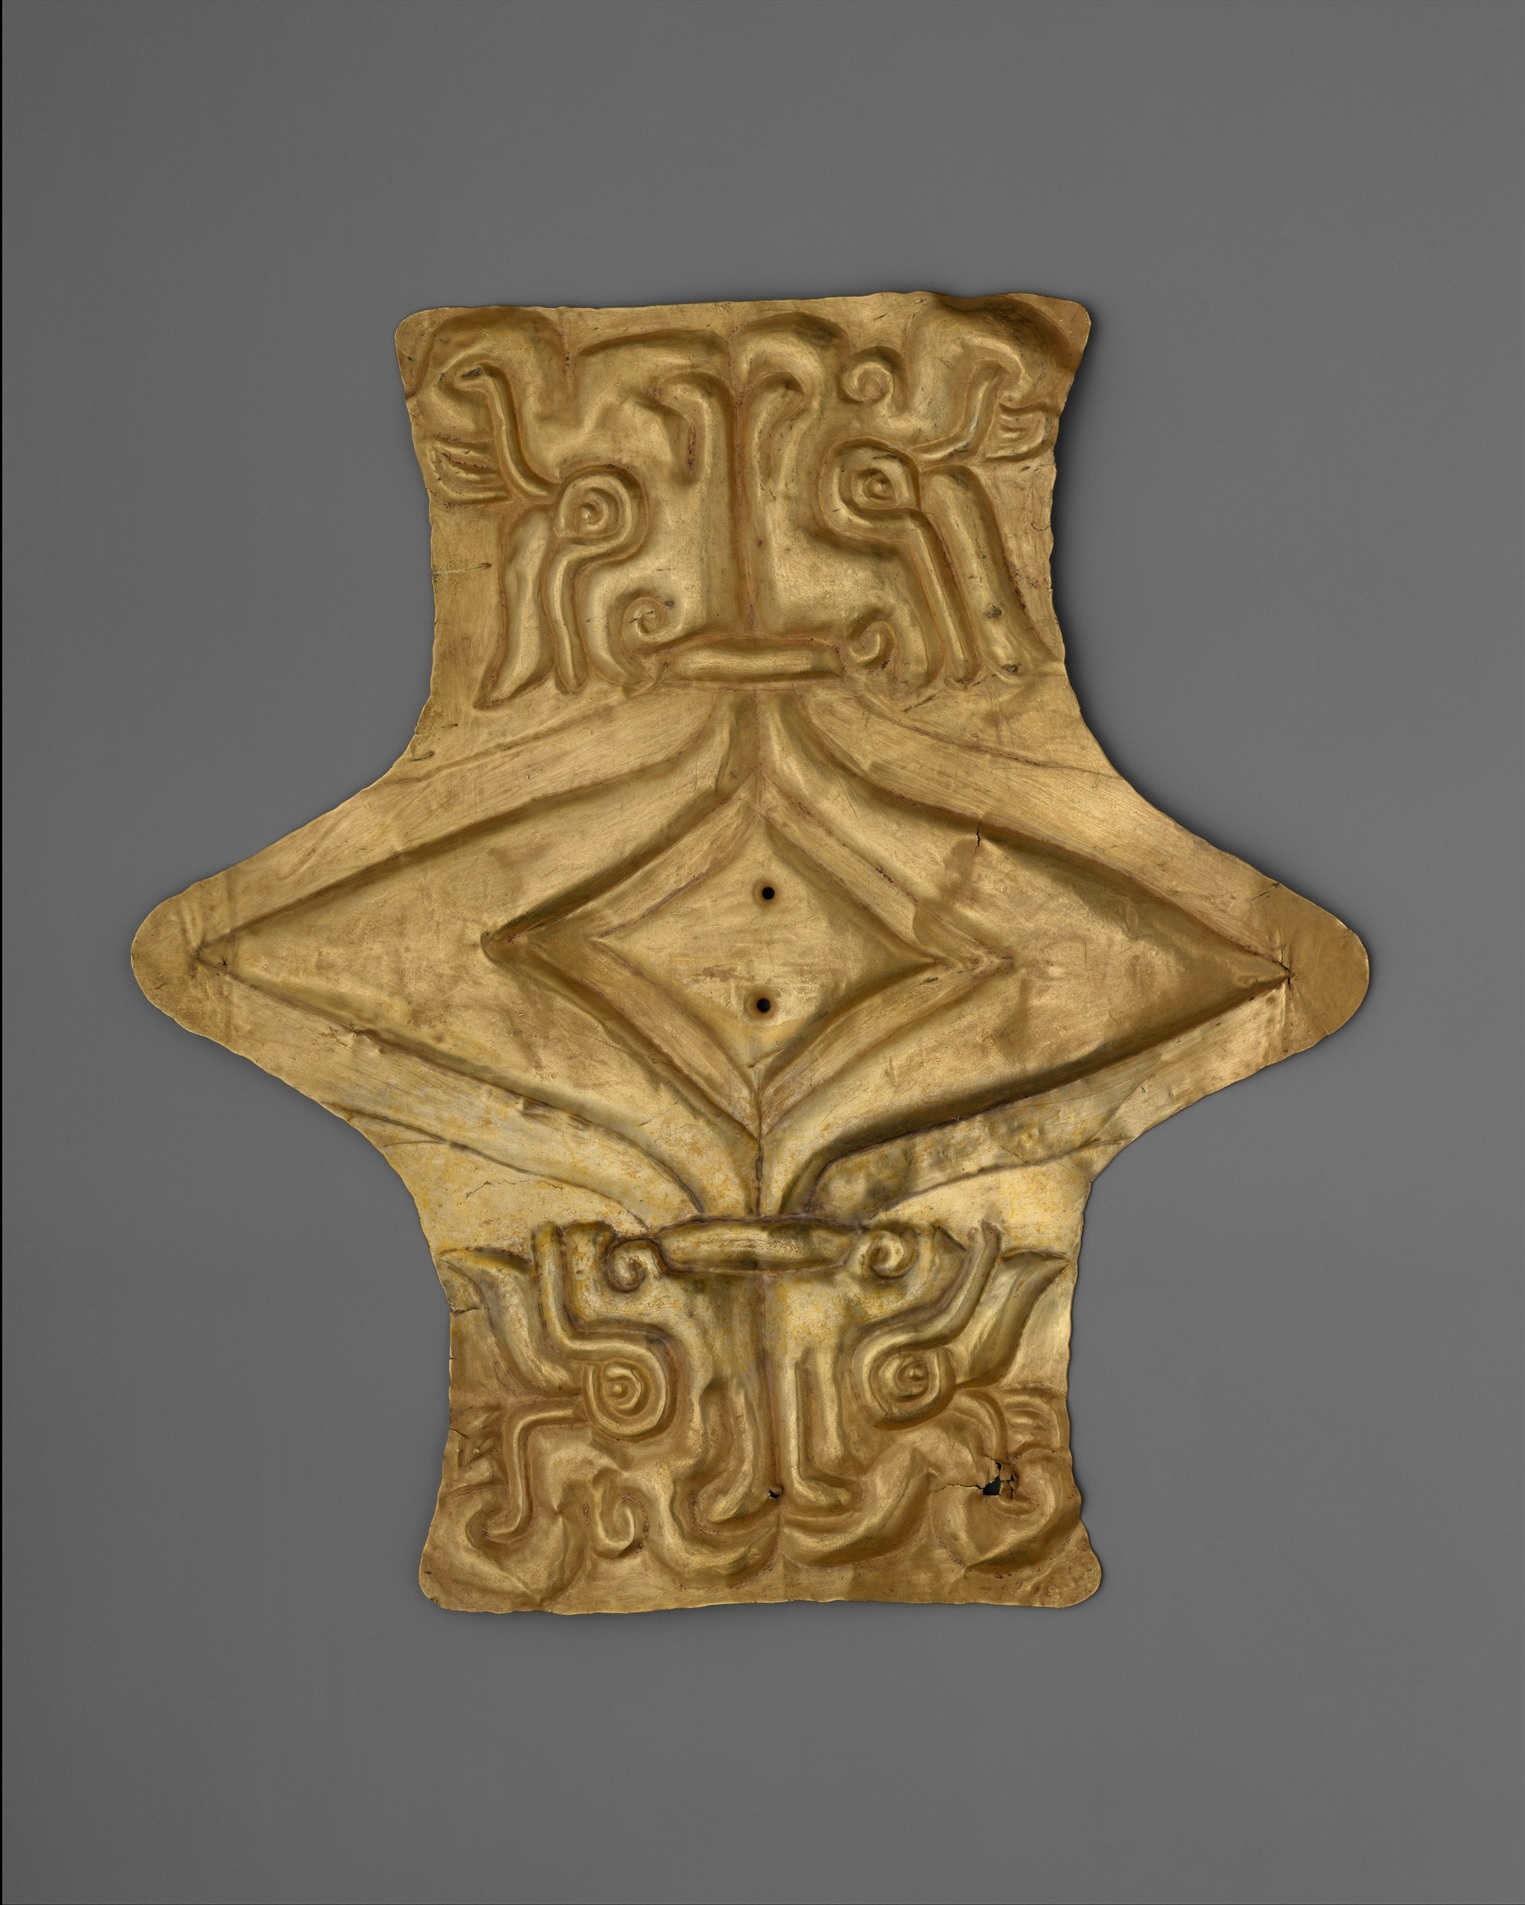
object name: pectoral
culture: chavín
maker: chavín artist(s)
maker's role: artist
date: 800-500 BCE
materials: gold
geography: peru